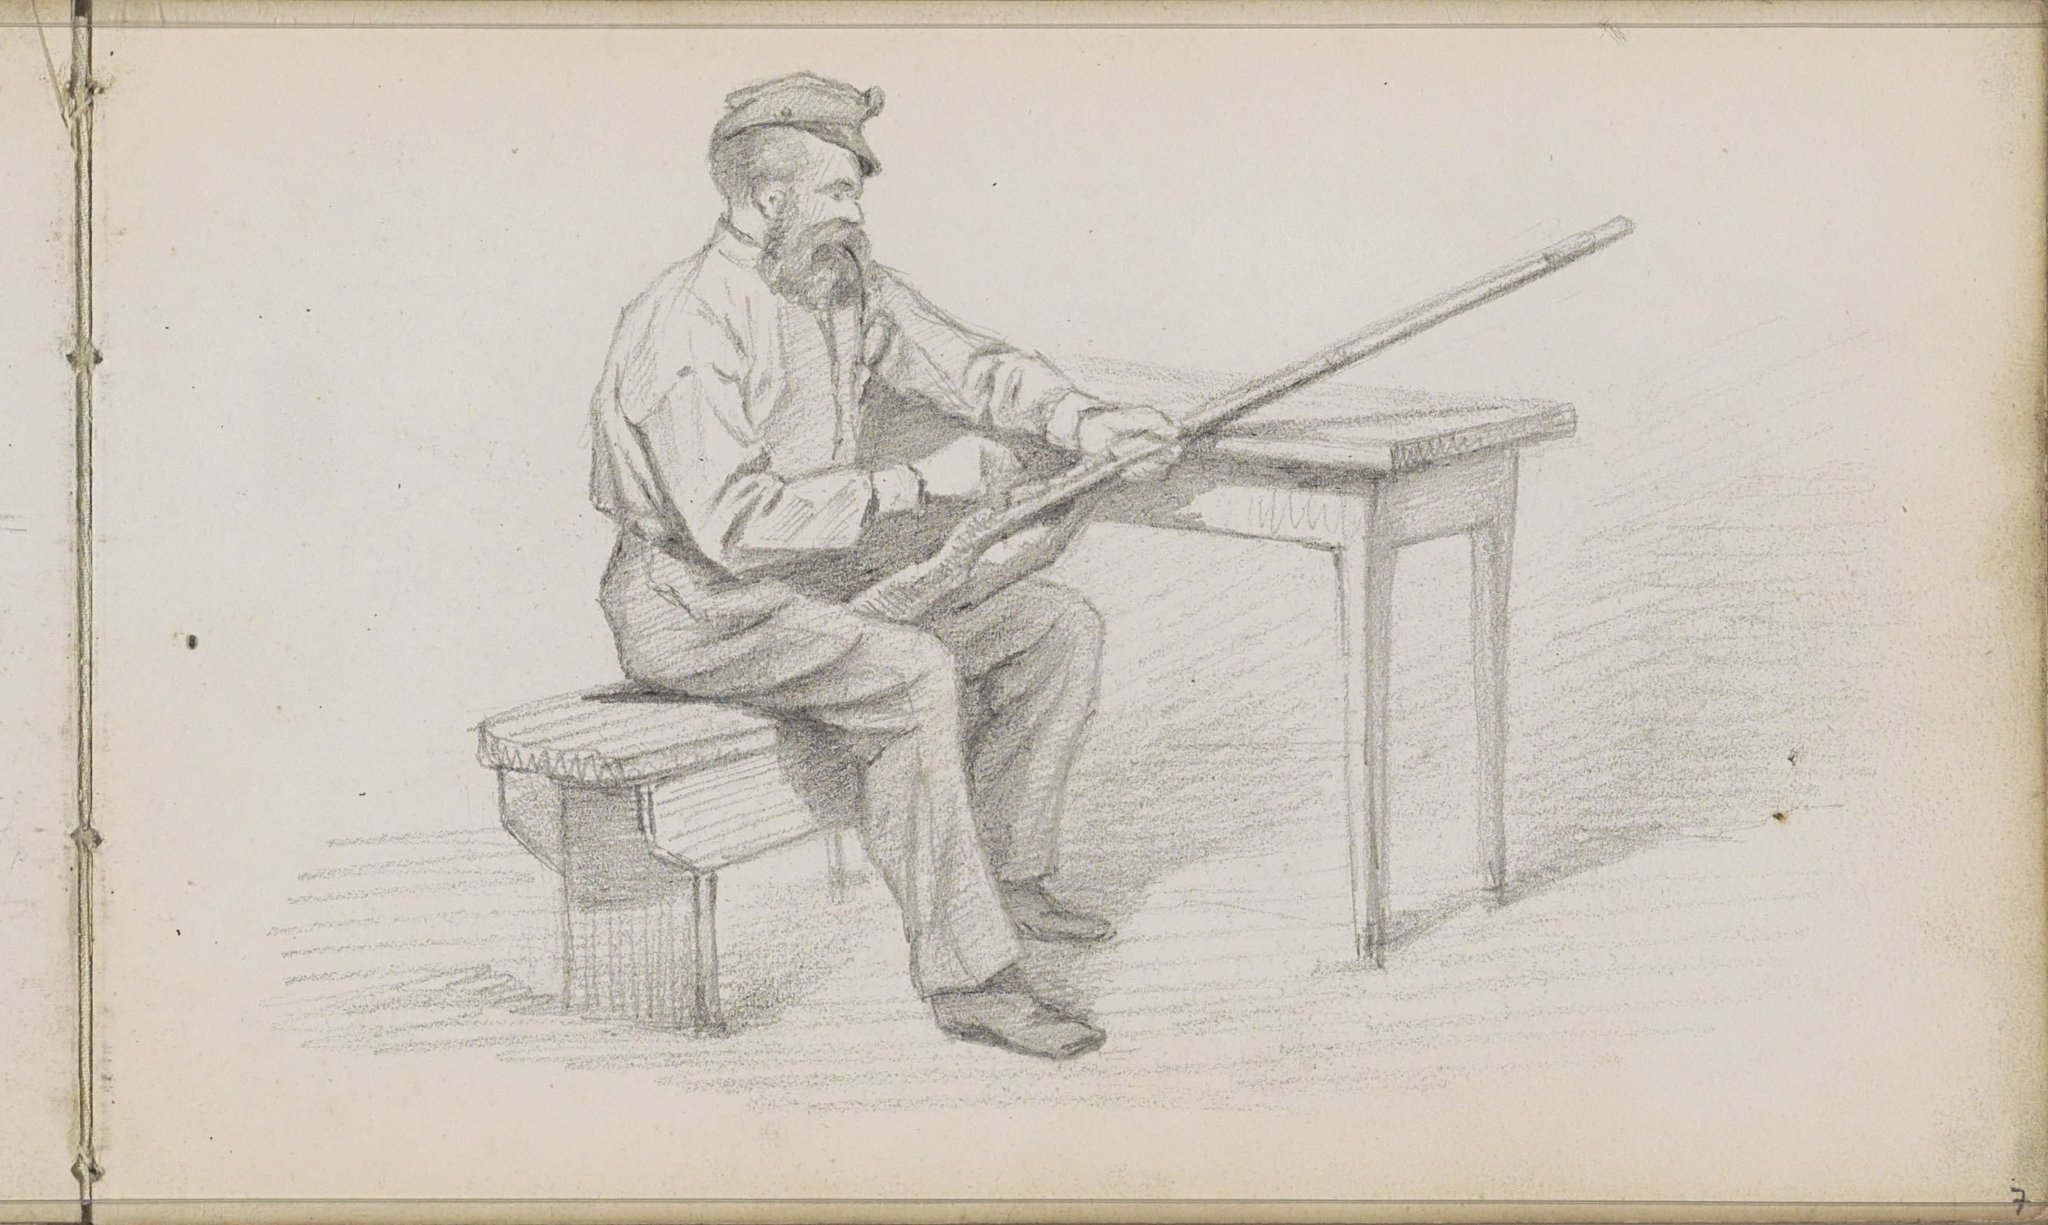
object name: sketchbook leaf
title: Man die een geweer laadt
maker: willem cornelis rip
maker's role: draughtsman, painter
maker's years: 1856-1922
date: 1874-1875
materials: paper, pencil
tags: sitting figure, firearms: rifle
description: Blad 7 recto uit een schetsboek met 46 bladen.